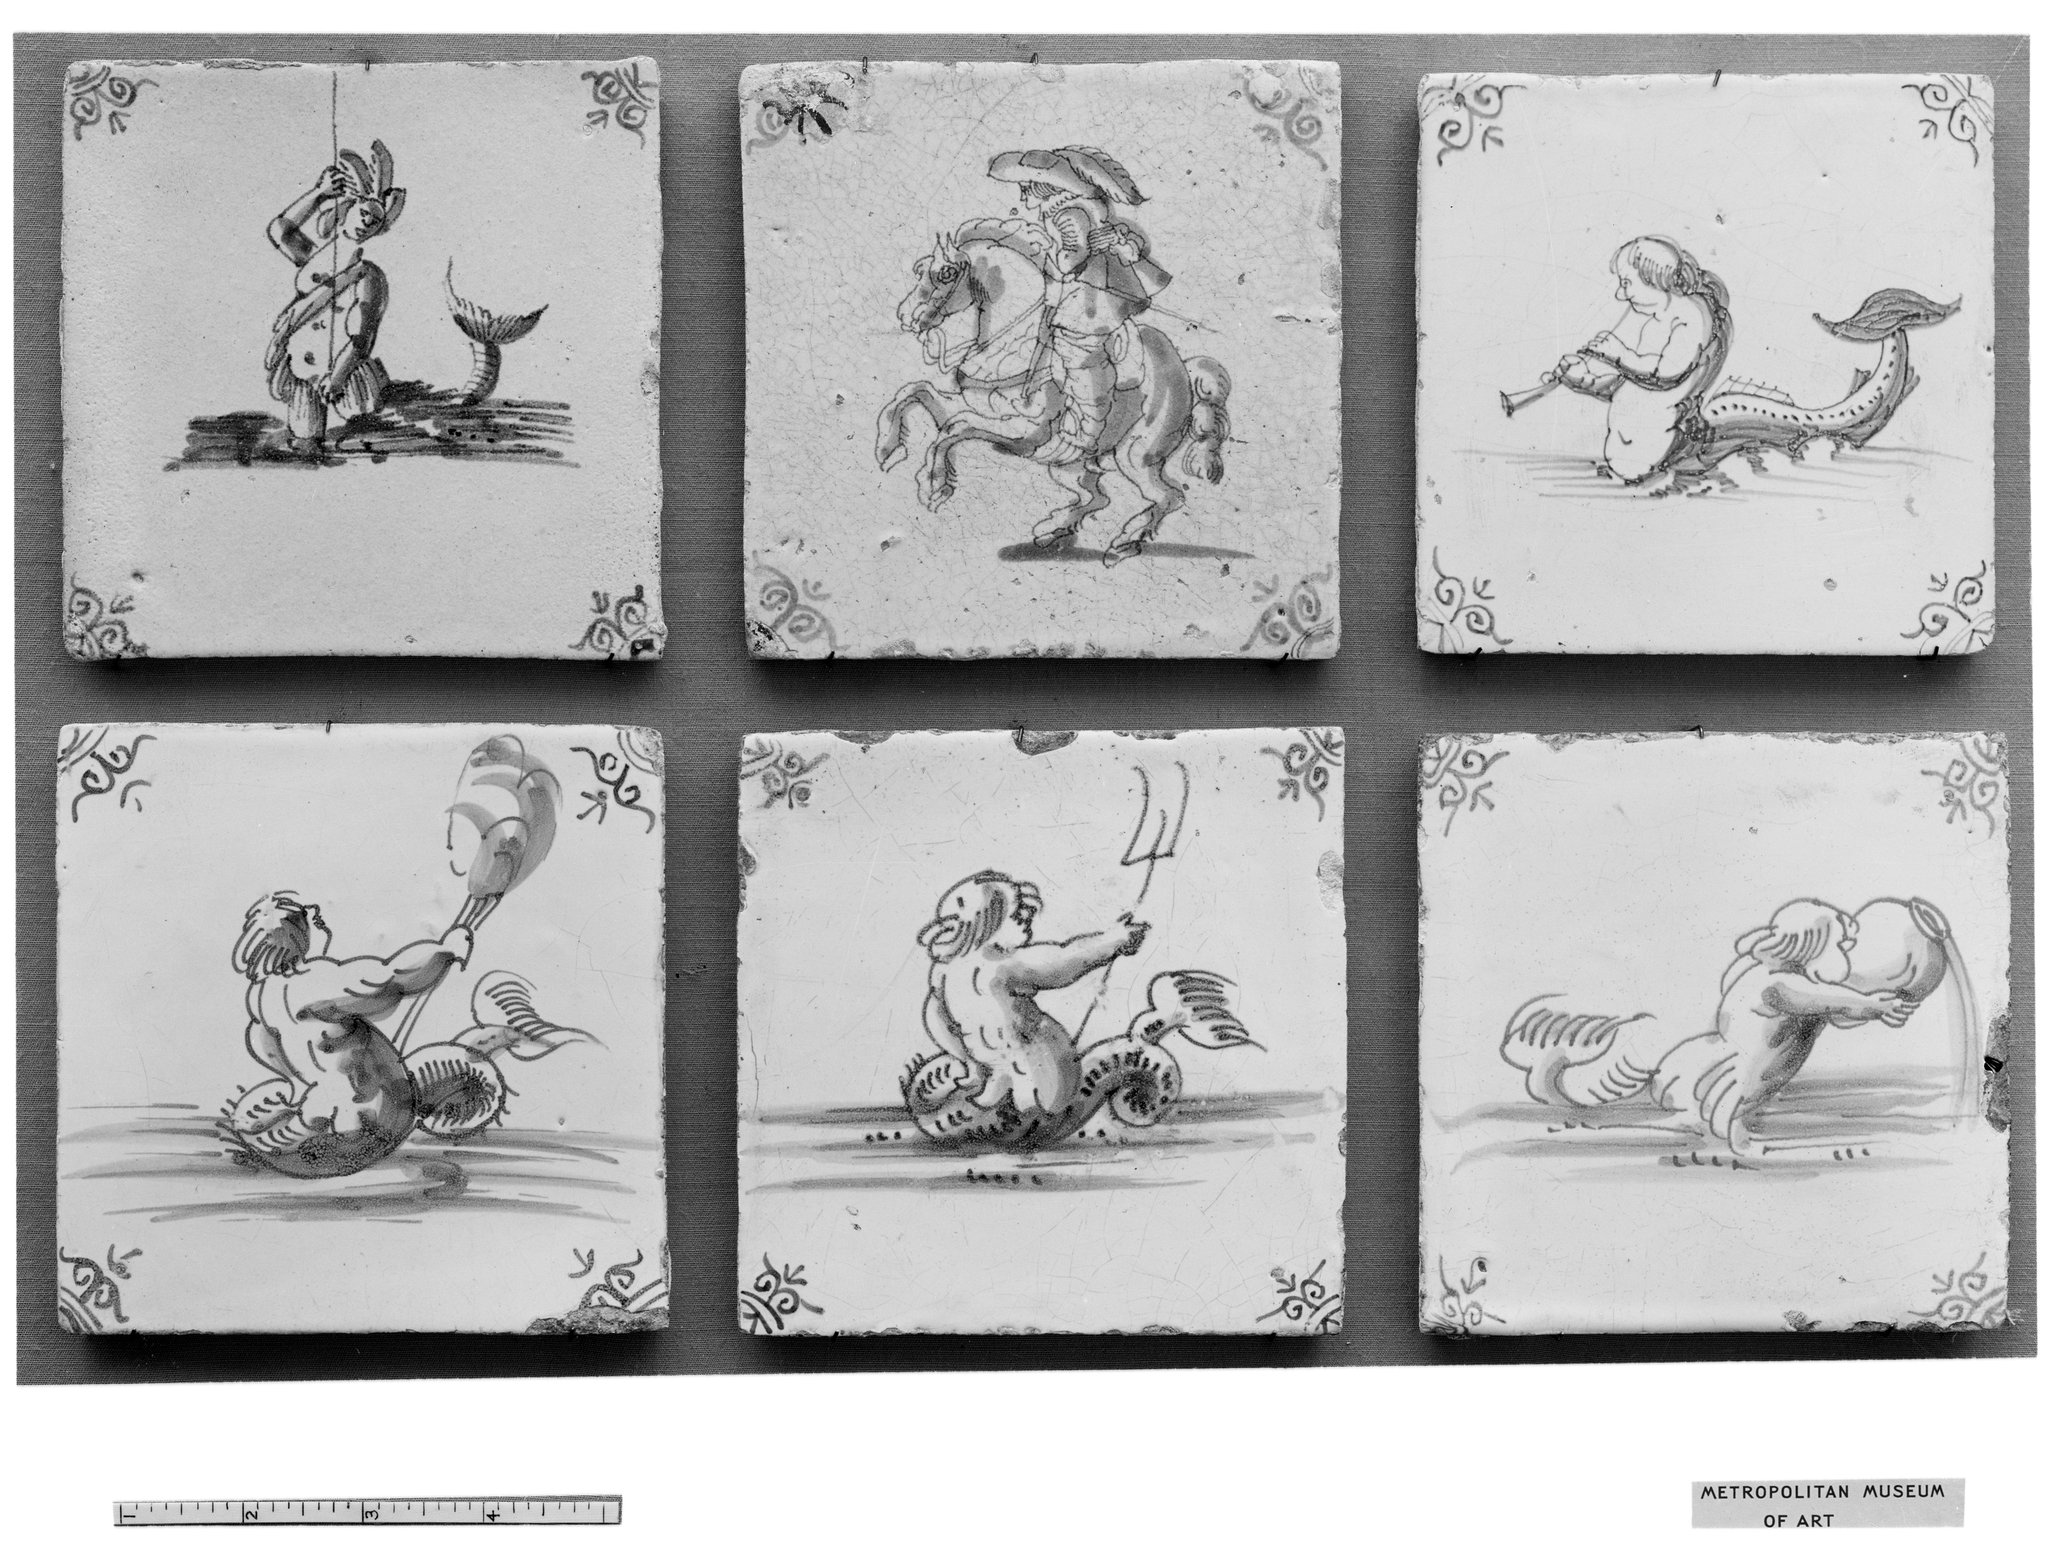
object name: tile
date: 1640-1660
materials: earthenware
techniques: glazing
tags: human figures,mermaids,horses